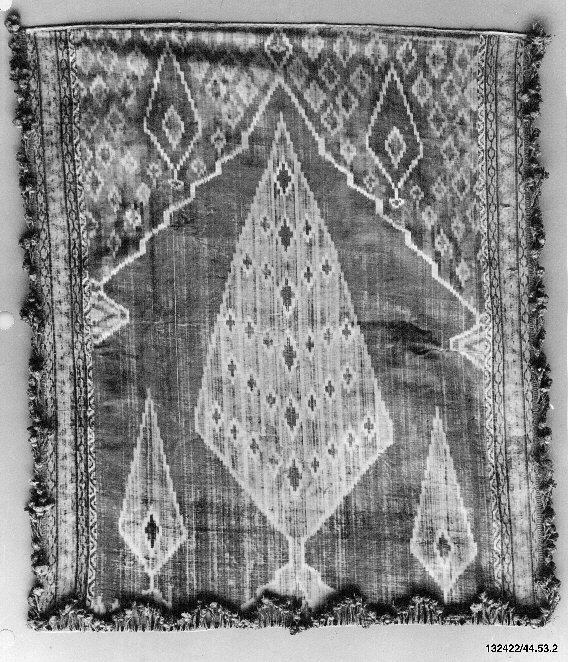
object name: hanging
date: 1801-1900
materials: silk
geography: uzbekistan